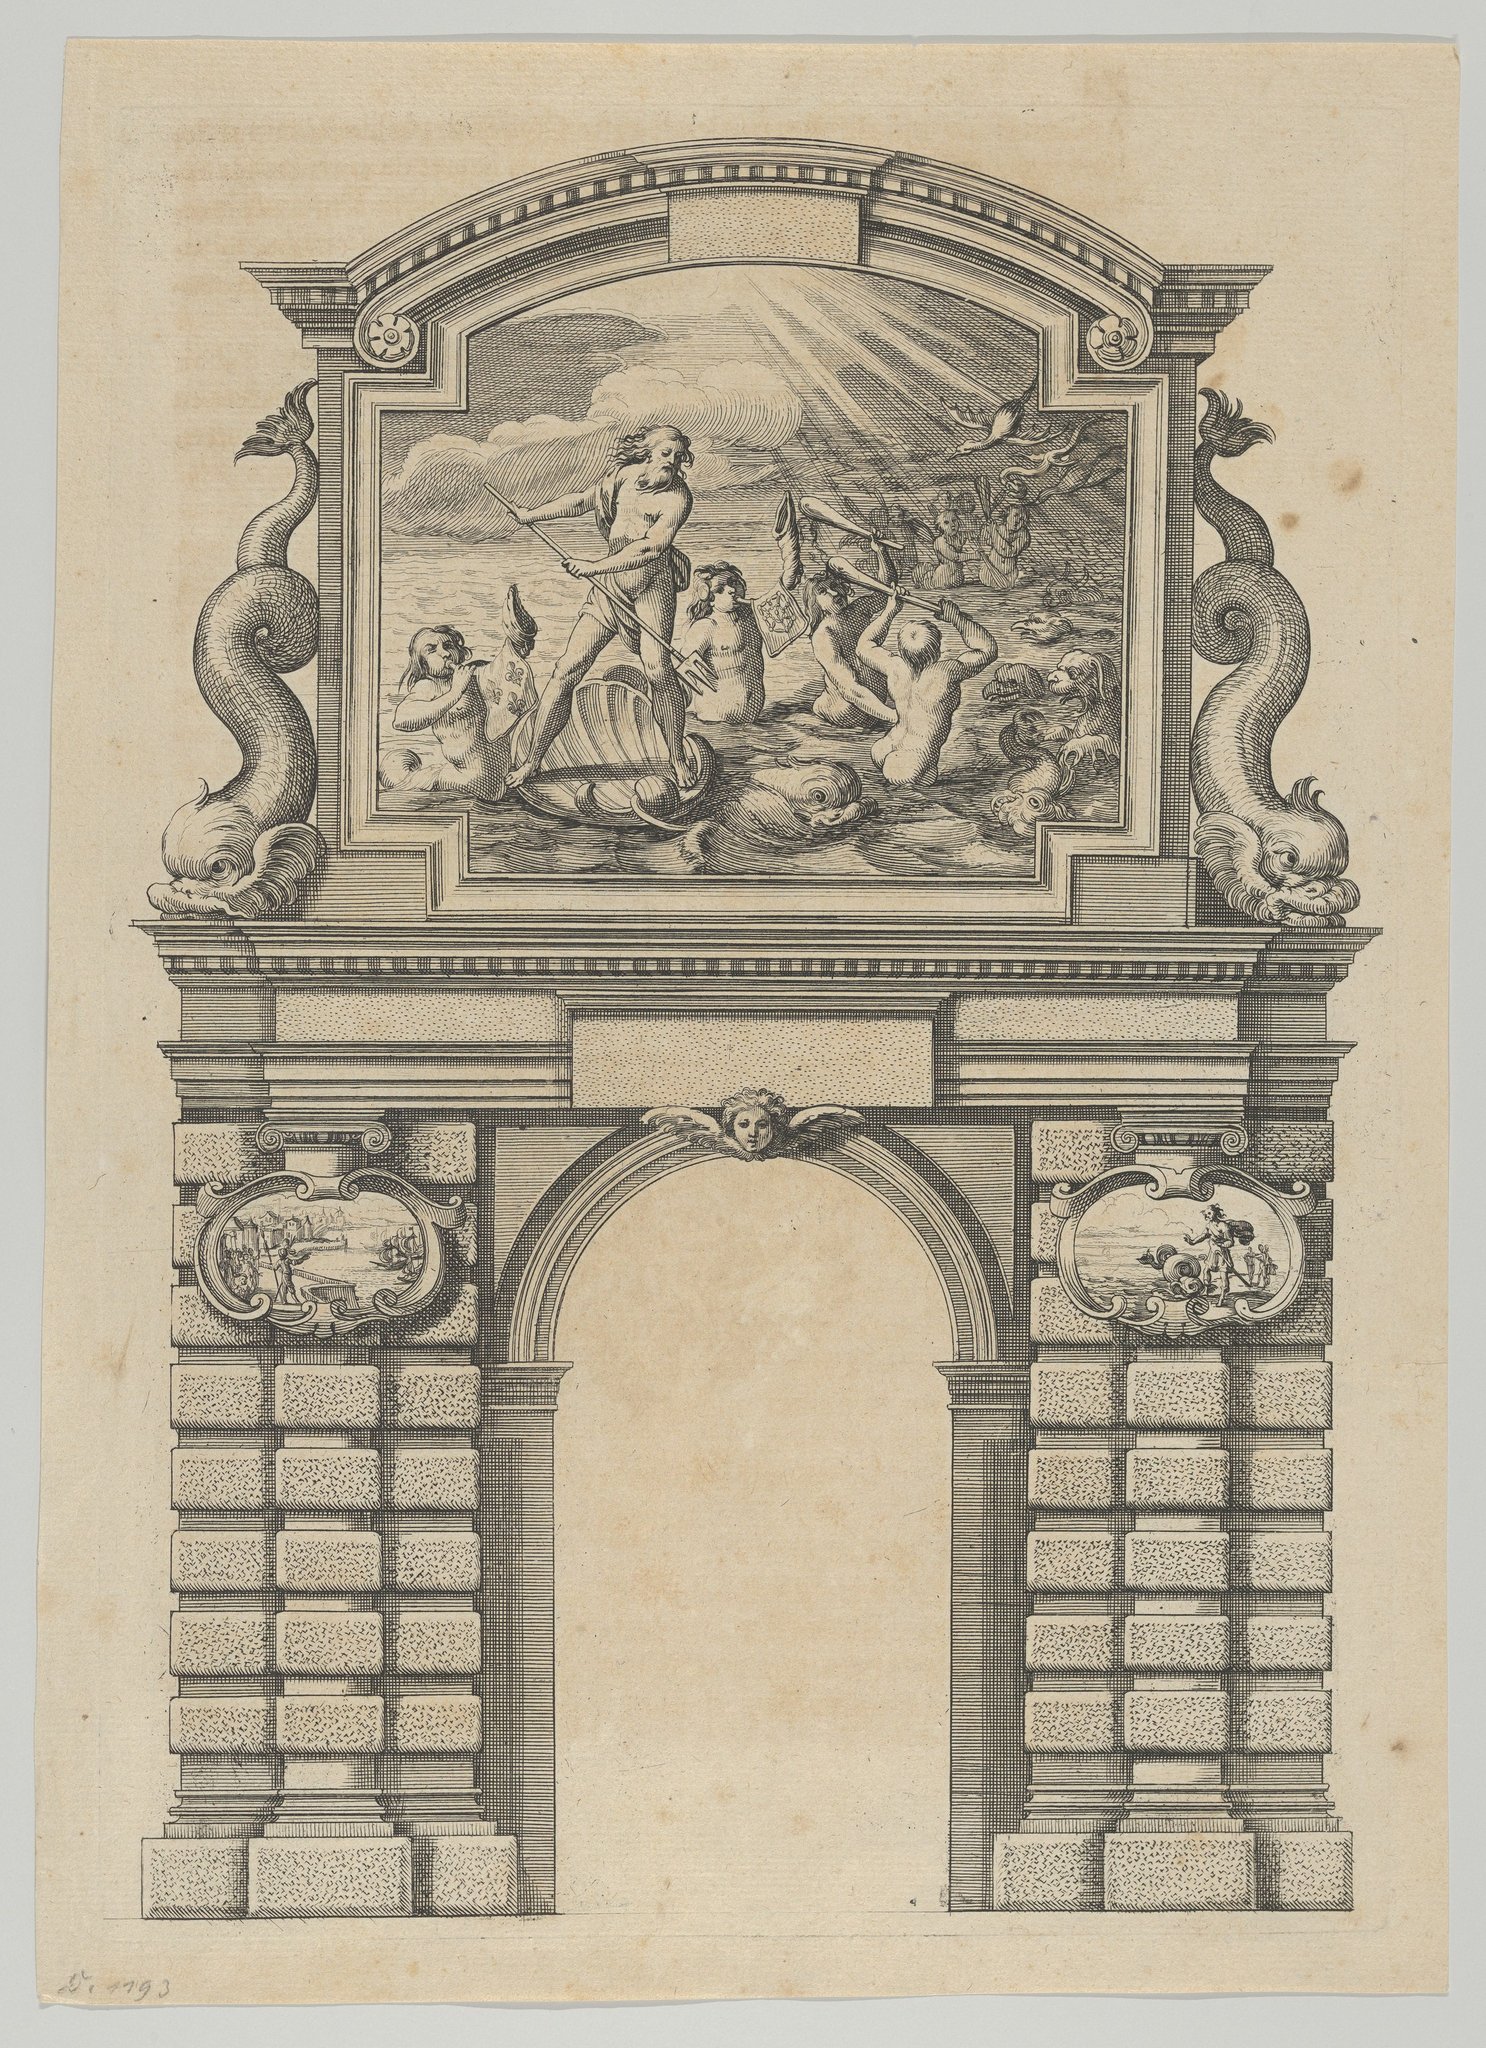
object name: print, fete, ornament architecture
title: Triumphal arch, from 'Éloges et discours sur la triomphante réception du Roy en sa ville de Paris ...' by Jean-Baptiste de Machault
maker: melchior tavernier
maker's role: artist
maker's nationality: french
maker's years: 1564-1641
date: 1629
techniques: etching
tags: arches